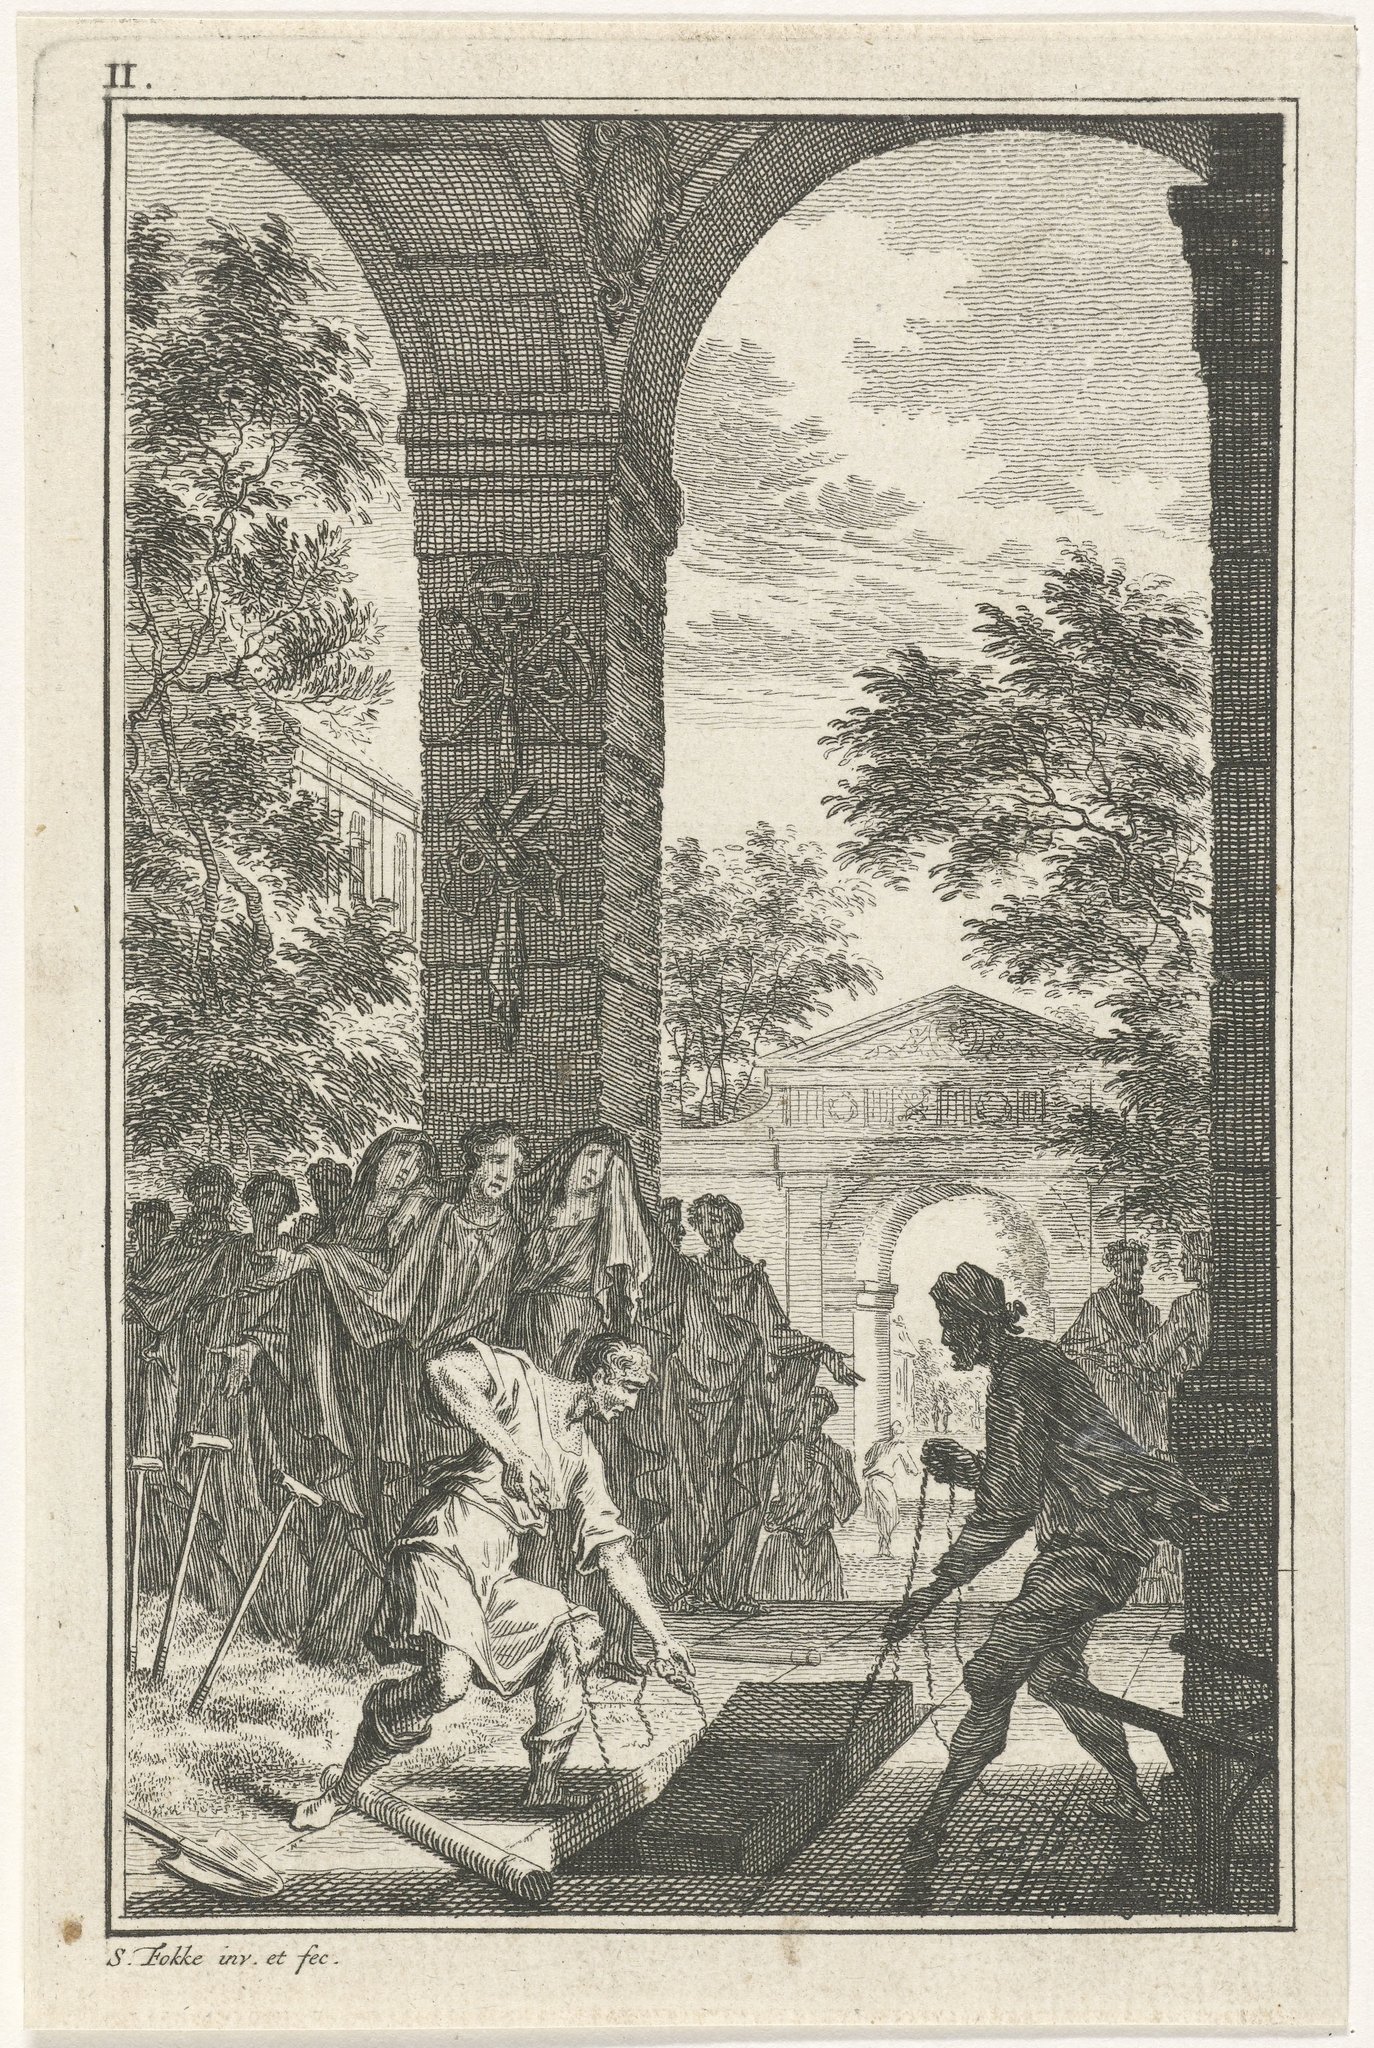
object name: print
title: Begrafenis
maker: simon fokke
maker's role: draughtsman, print maker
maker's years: 1712-1784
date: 1722-1784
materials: paper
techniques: etching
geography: amsterdam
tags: burial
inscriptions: collector's mark: Lugt 2228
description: Gesluierde vrouwen en mannen kijken met geheven armen toe hoe twee grafgravers een doodskist in de grond laten zakken. Prent rechtsboven gemerkt: II.